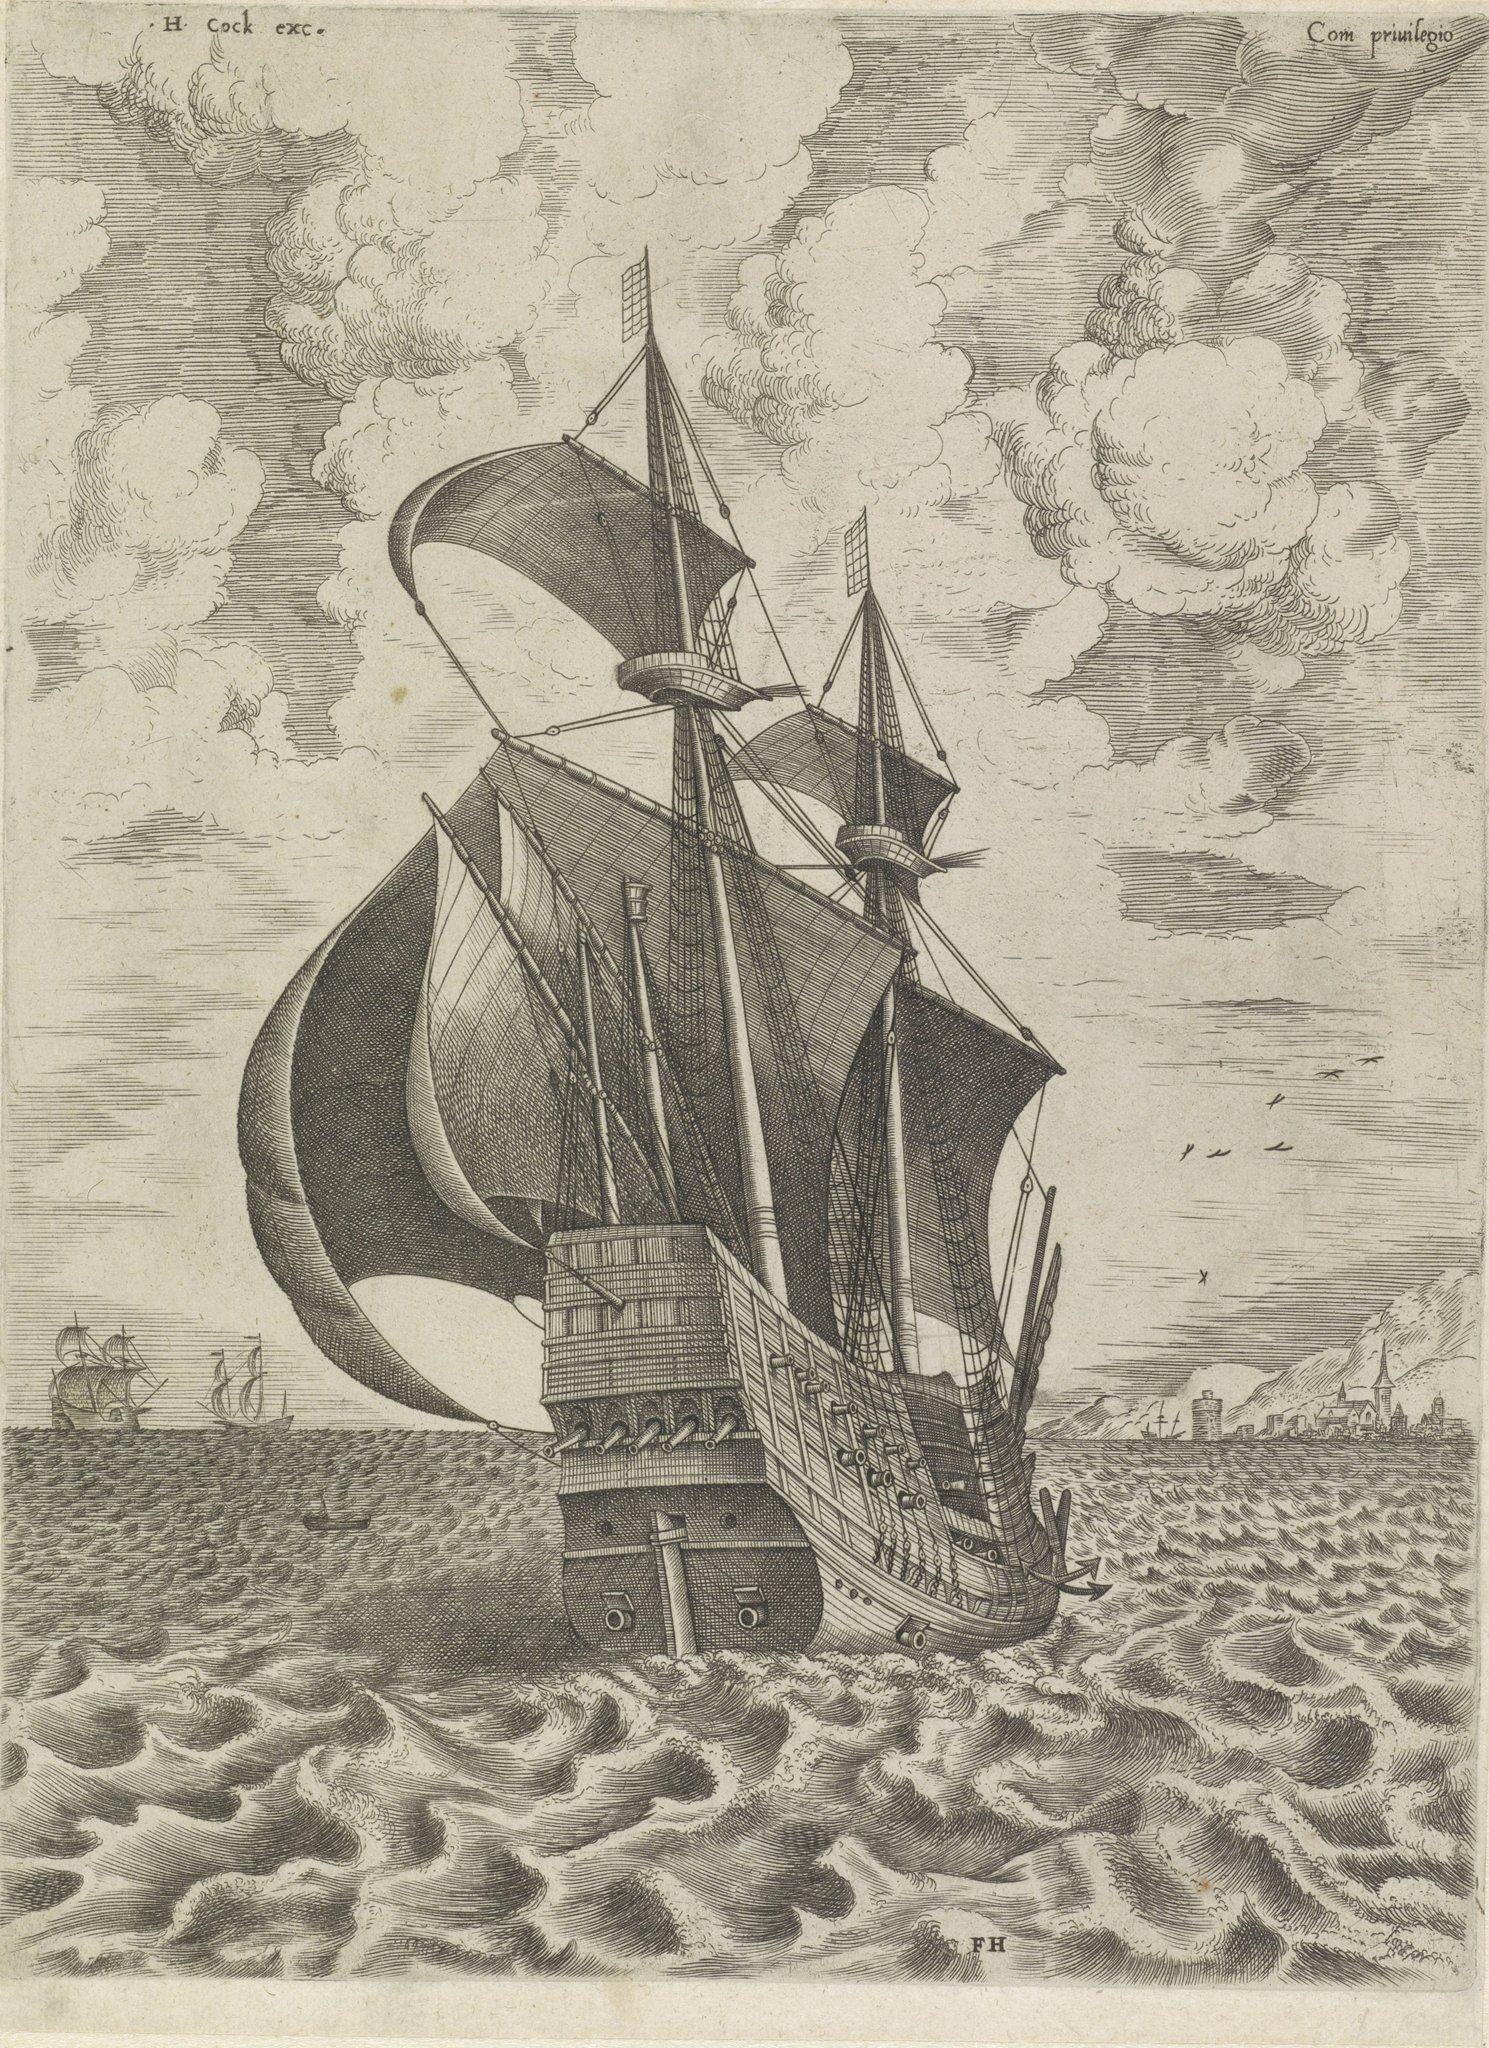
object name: print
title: Zeilschepen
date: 1561-1565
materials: paper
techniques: engraving, etching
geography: antwerp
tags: ships (in general)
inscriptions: collector's mark: Lugt 2228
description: Oorlogsschip op weg naar de haven. Het schip op de spiegel gezien. Aan de horizon twee kleine scheepjes en de havenstad aan de voet van heuvels.